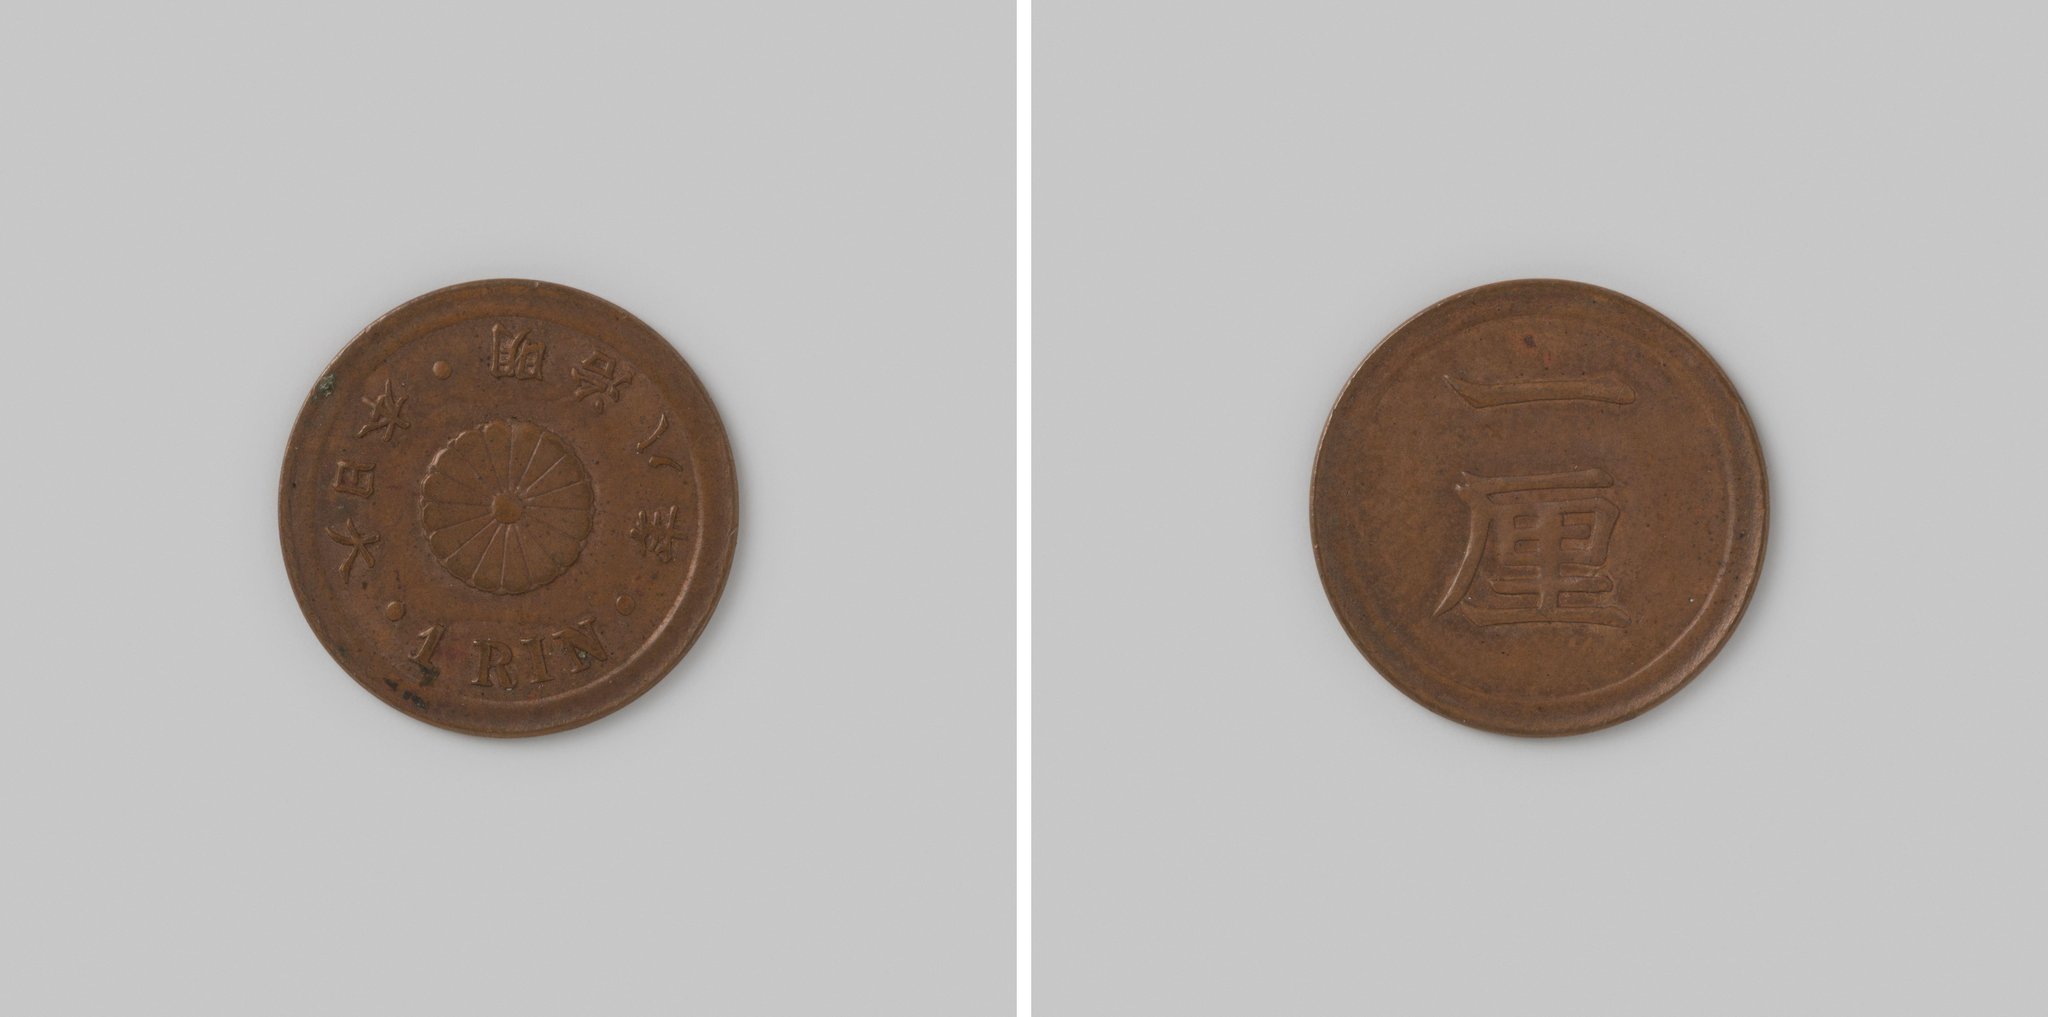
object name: rin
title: Keizerrijk Japan, Meiji tijdperk, rin = 1/10 sen, regeringsjaar 8 [=1875]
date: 1875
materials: copper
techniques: striking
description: Koperen munt. Voorzijde: binnen cirkel crysanthemum met in omschrift onderaan waarde-aanduiding: 1 rin. Keerzijde: op twee regels onder elkaar waarde-aanduiding. Gladde rand.